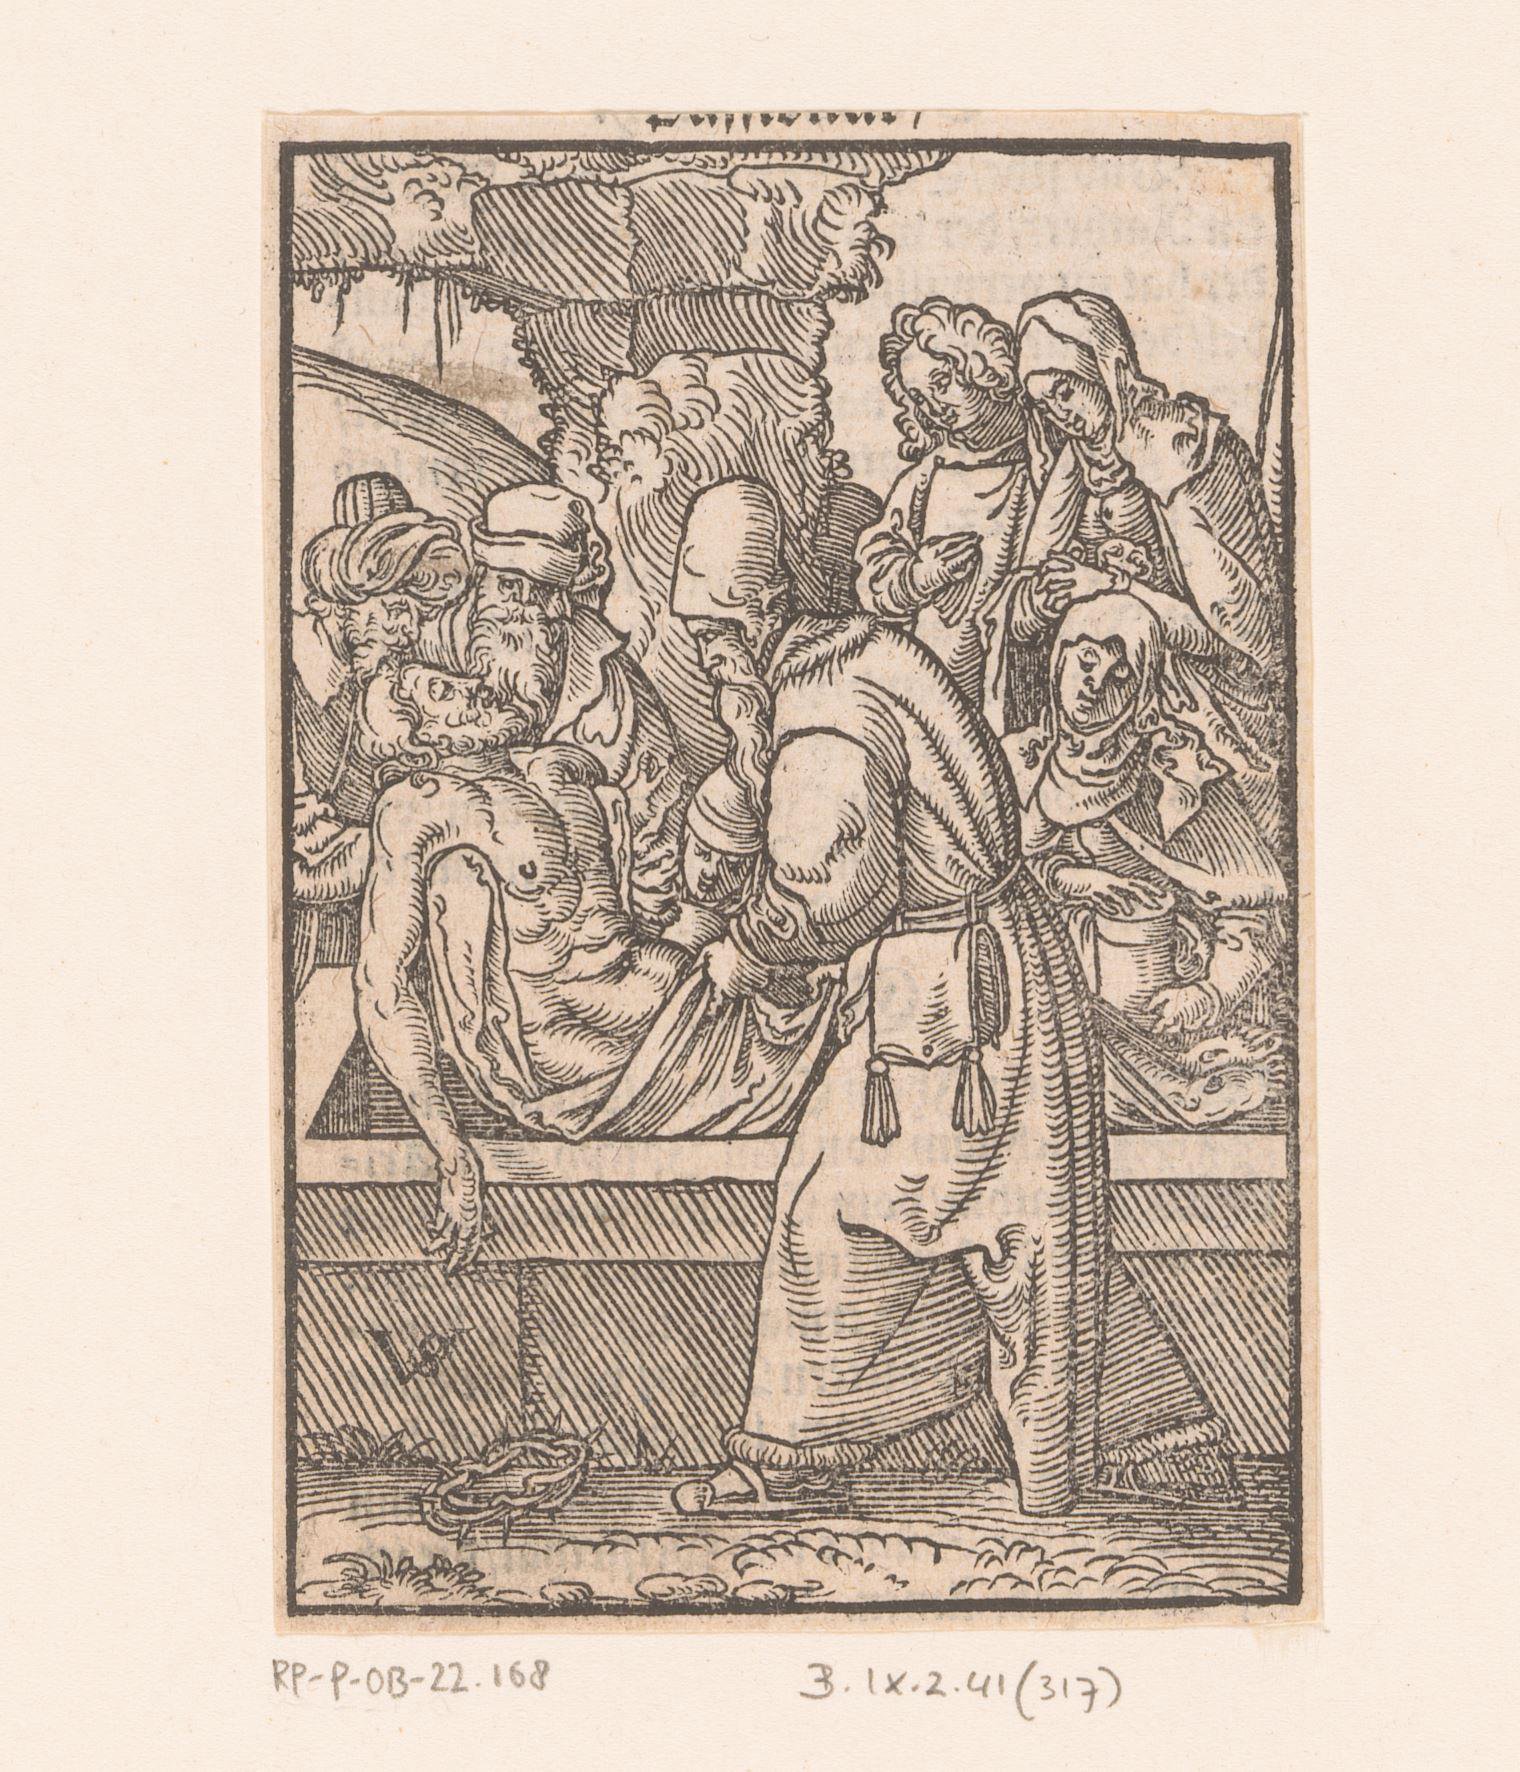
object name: print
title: Graflegging van Christus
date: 1552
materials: paper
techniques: woodcut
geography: nuremberg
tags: christ's entombment (possibly by angels)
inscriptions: number: ‘181’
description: Gebruikt voor verschillende publicaties die werden gedrukt door Valentin Geißler tussen 1552 en 1560 te Neurenberg.